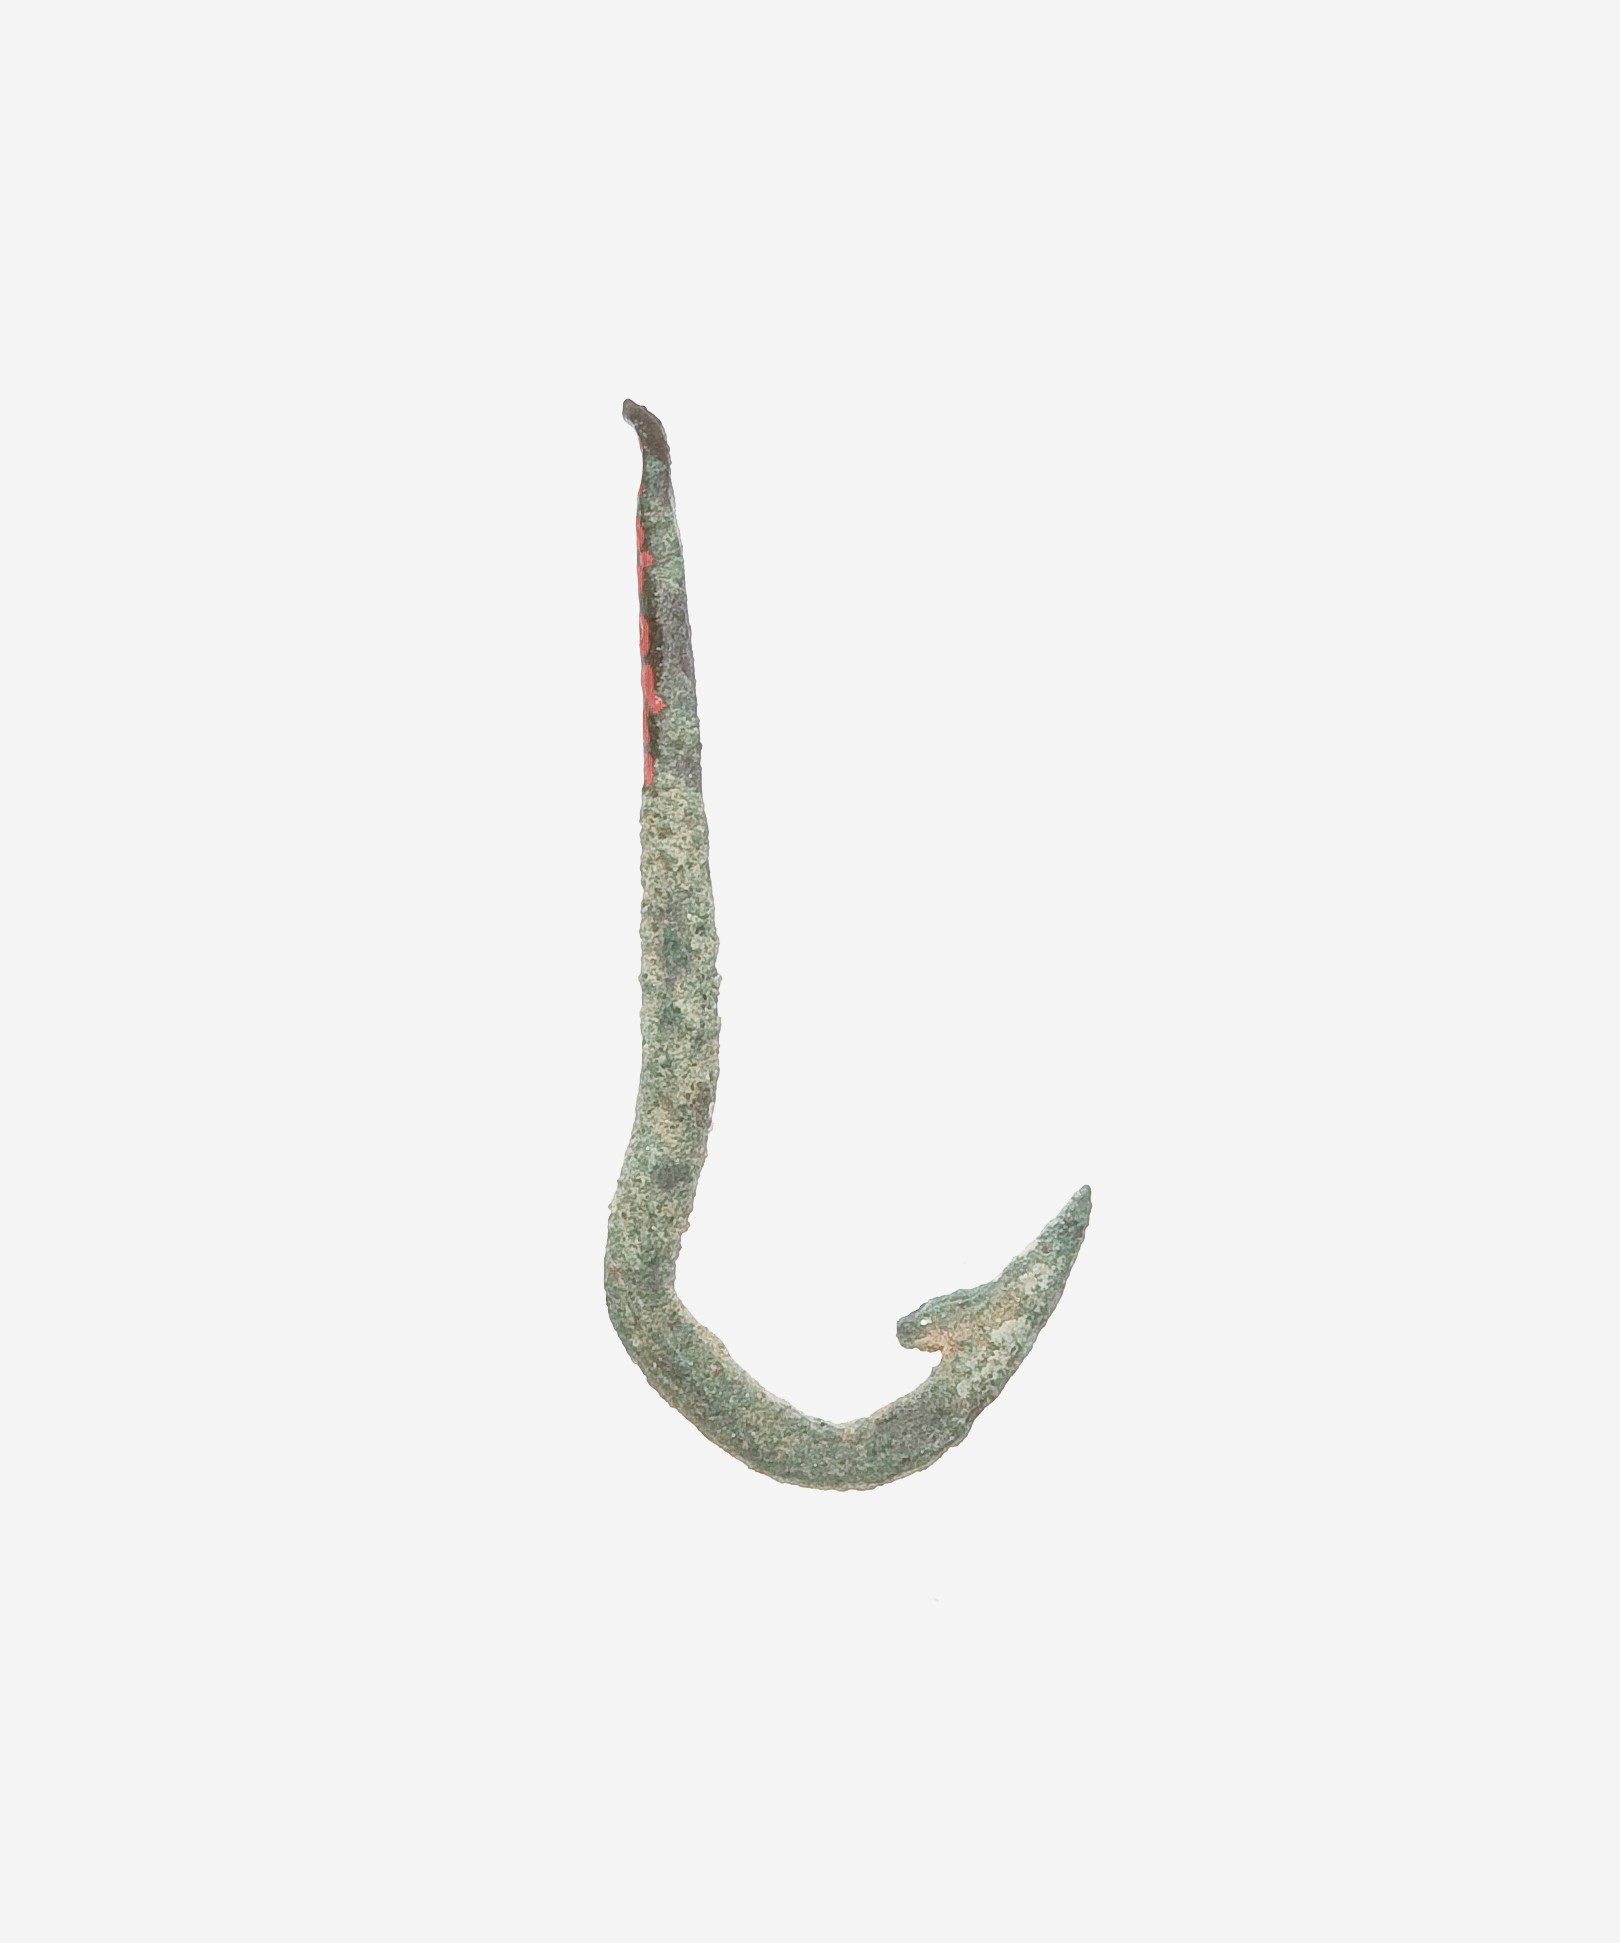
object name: fish hook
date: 1390-1352 BCE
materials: bronze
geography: egypt